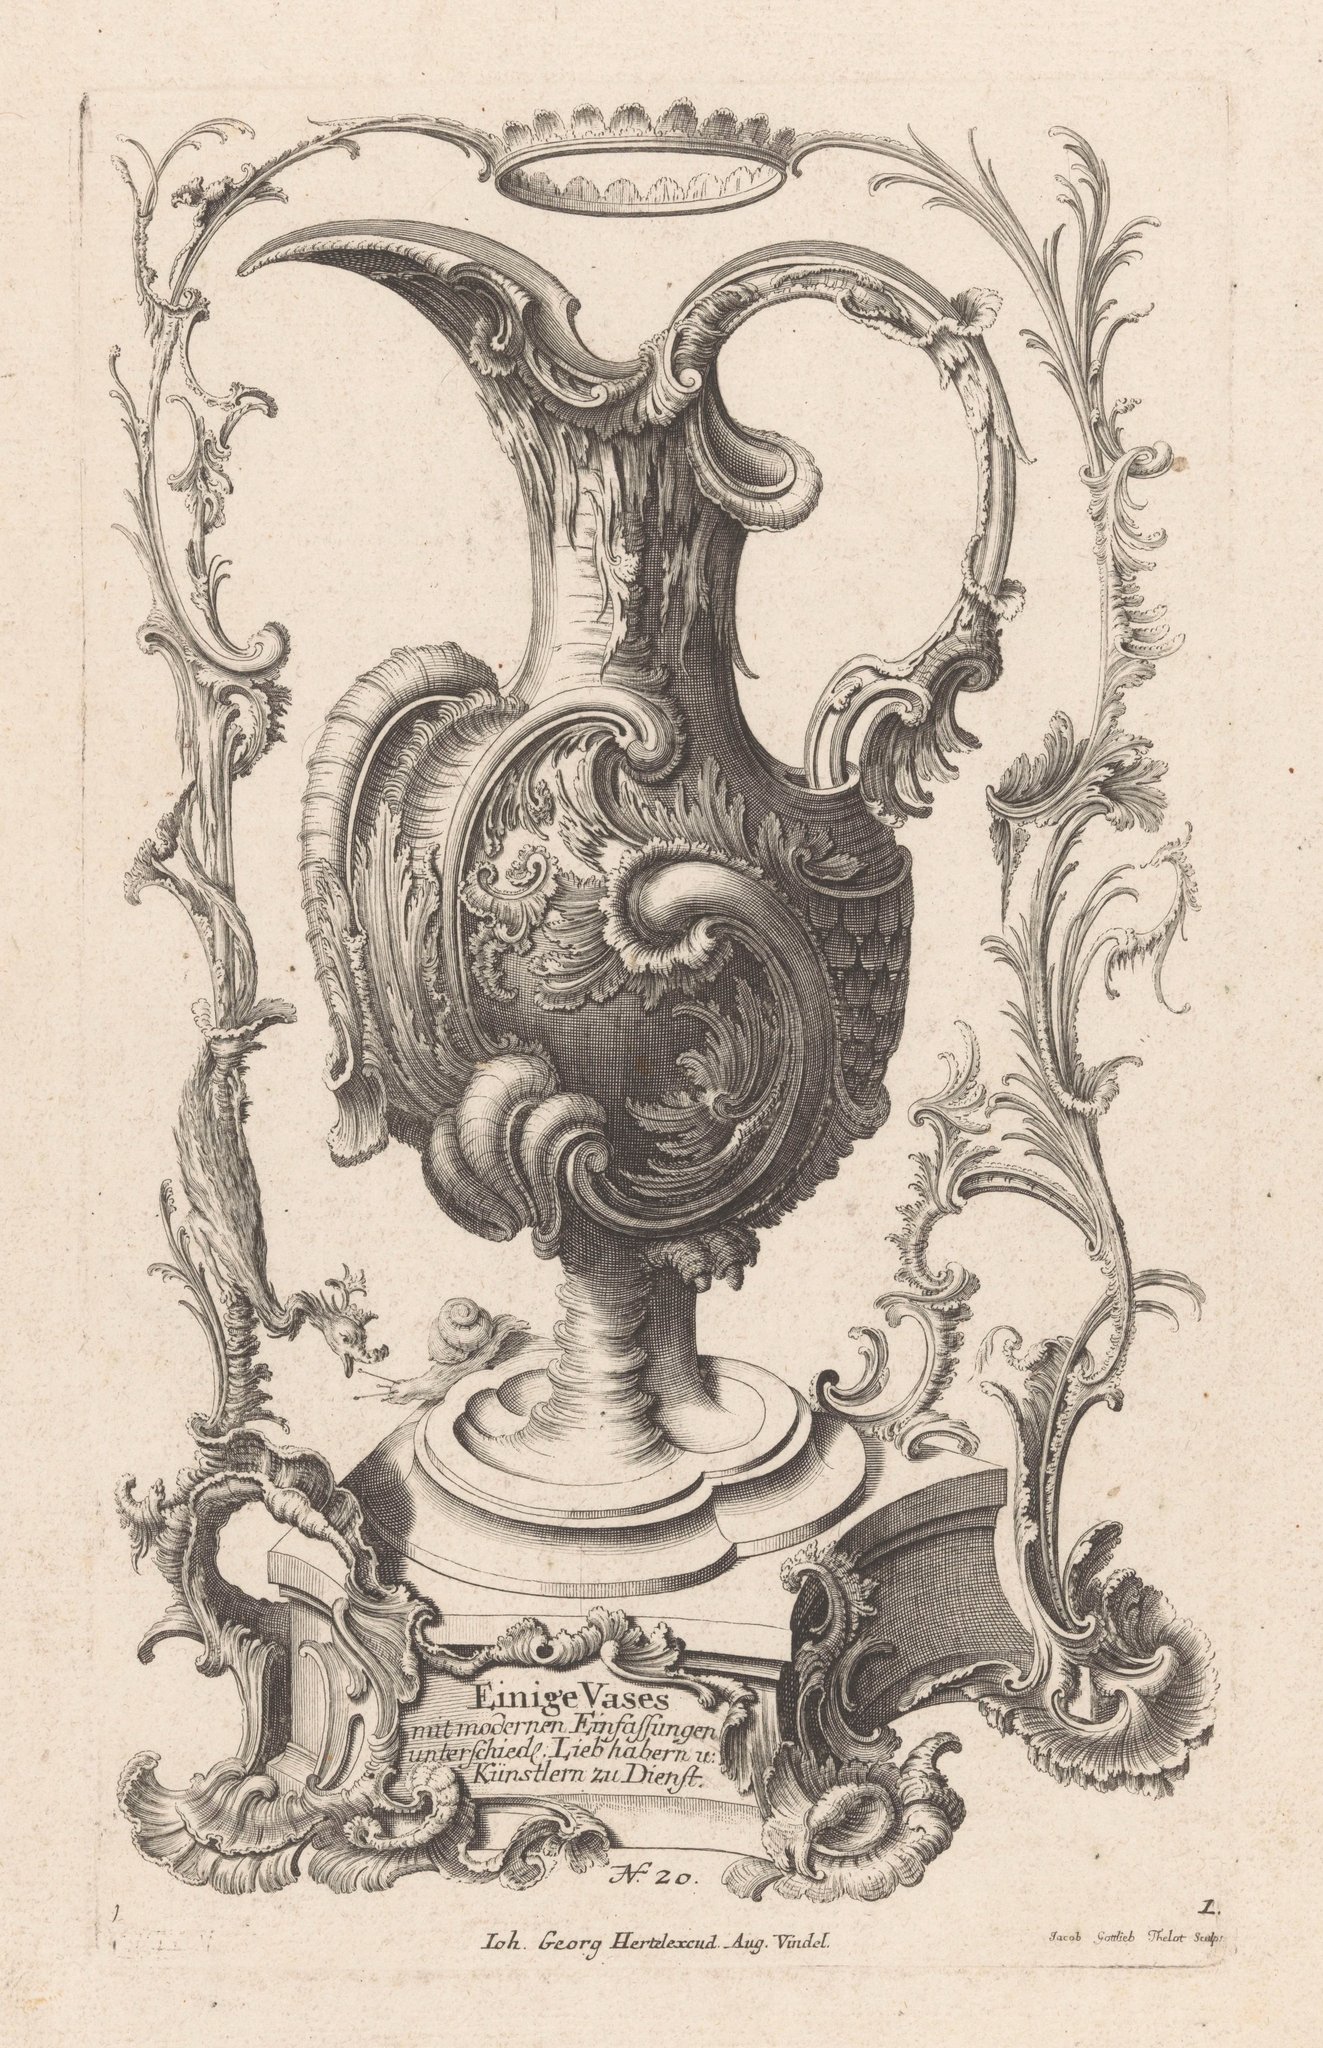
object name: ornament print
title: Siervazen en -kannen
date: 1718-1760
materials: paper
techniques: etching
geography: augsburg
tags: crown (symbol of sovereignty), rocaille ornament, jar, jug (used as drinking-vessel), molluscs: snail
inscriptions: collector's mark: Lugt 2228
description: Een sierkan met rocaille ornamenten en een slak staat op een voetstuk met de serietitel. Rondom de kan een rocaille omlijsting met een kroon en een draakachtig wezen. Uitgeversnummer 20.